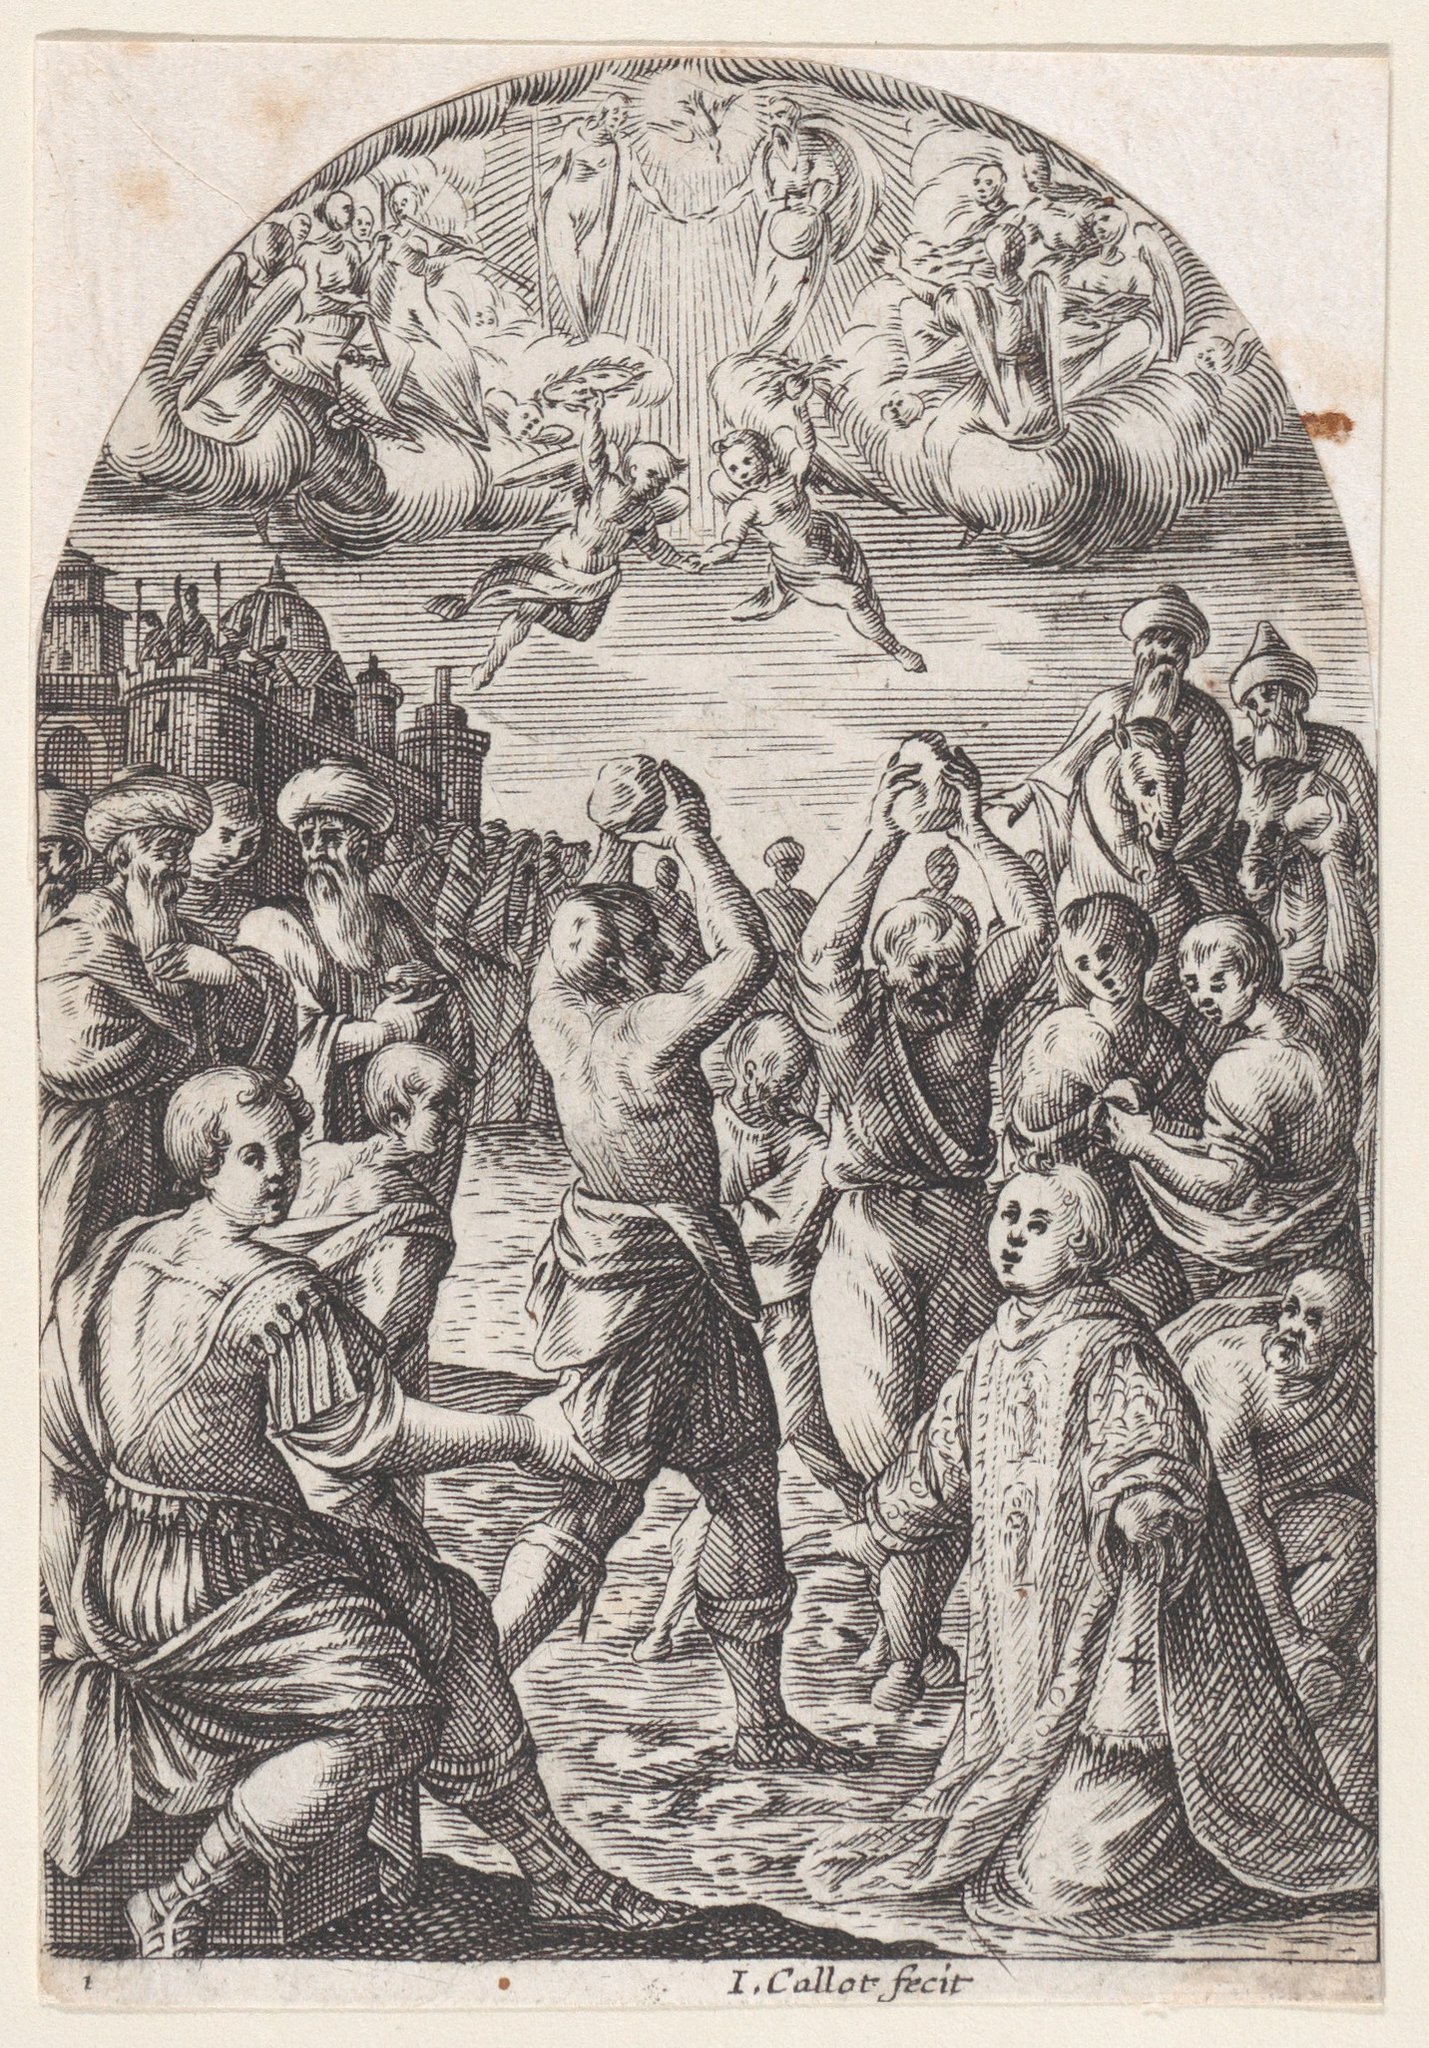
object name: print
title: The Martyrdom of St. Stephen, plate 1 from "Les Tableaux de Rome, Les Eglises Jubilaires" (The Paintings of Rome, The Churches Jubilee)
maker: jacques callot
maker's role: artist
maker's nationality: french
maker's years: 1592-1635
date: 1607-1611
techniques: engraving